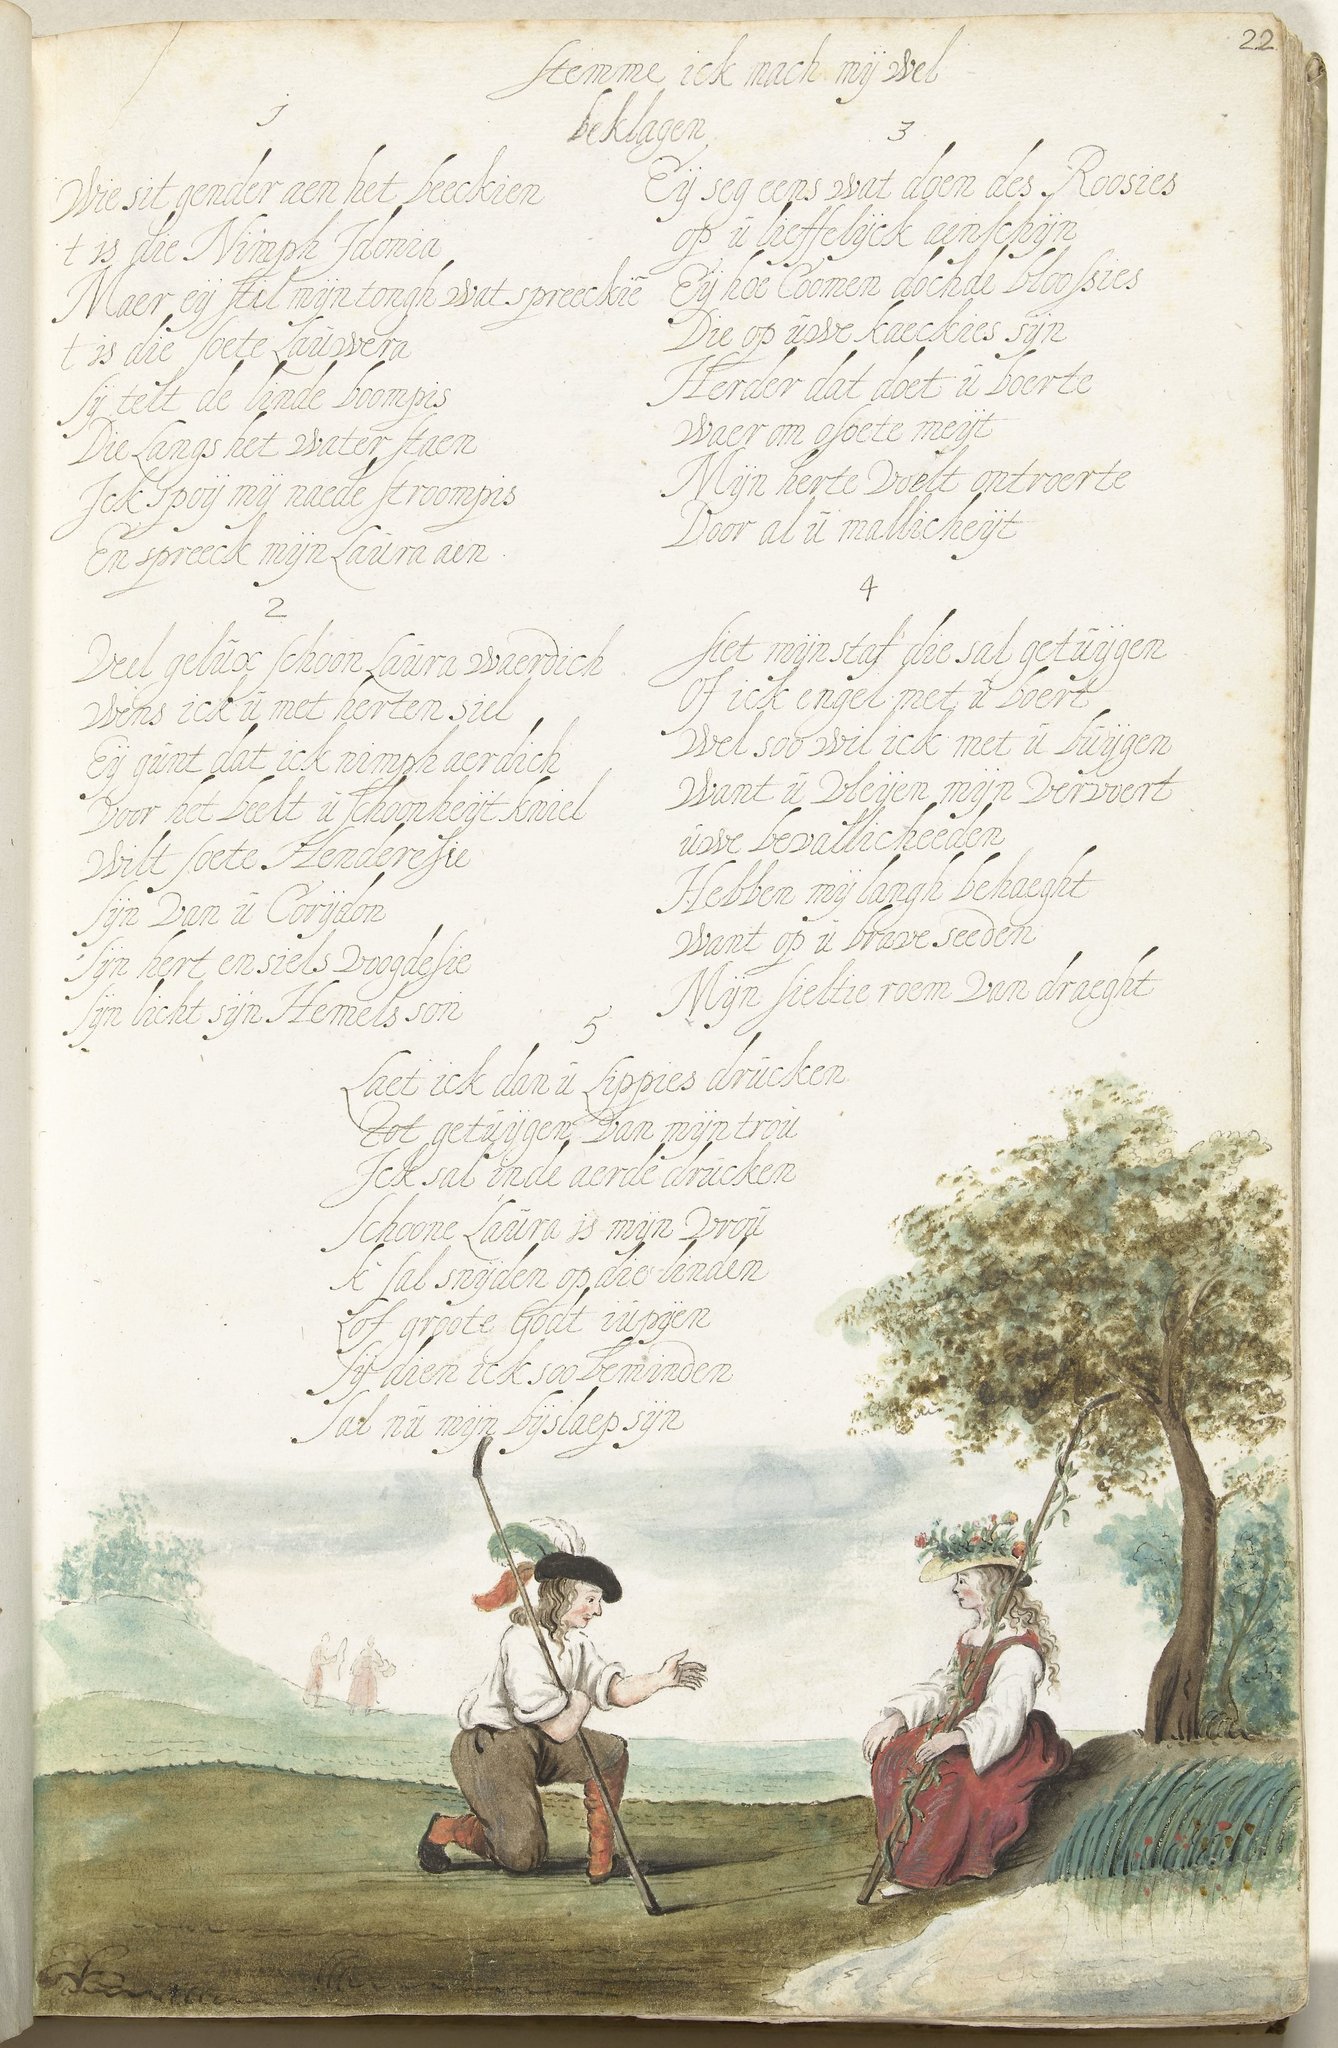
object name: poem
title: Herder knielend voor een herderin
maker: gesina ter borch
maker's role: draughtsman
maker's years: 1633-1690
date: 1652-1653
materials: ink, paper, watercolor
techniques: brush, calligraphy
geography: zwolle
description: Coridon knielend voor de herderin Laura, onder een pastoraal gedicht op de melodie van Ick mach mij wel beklagen.